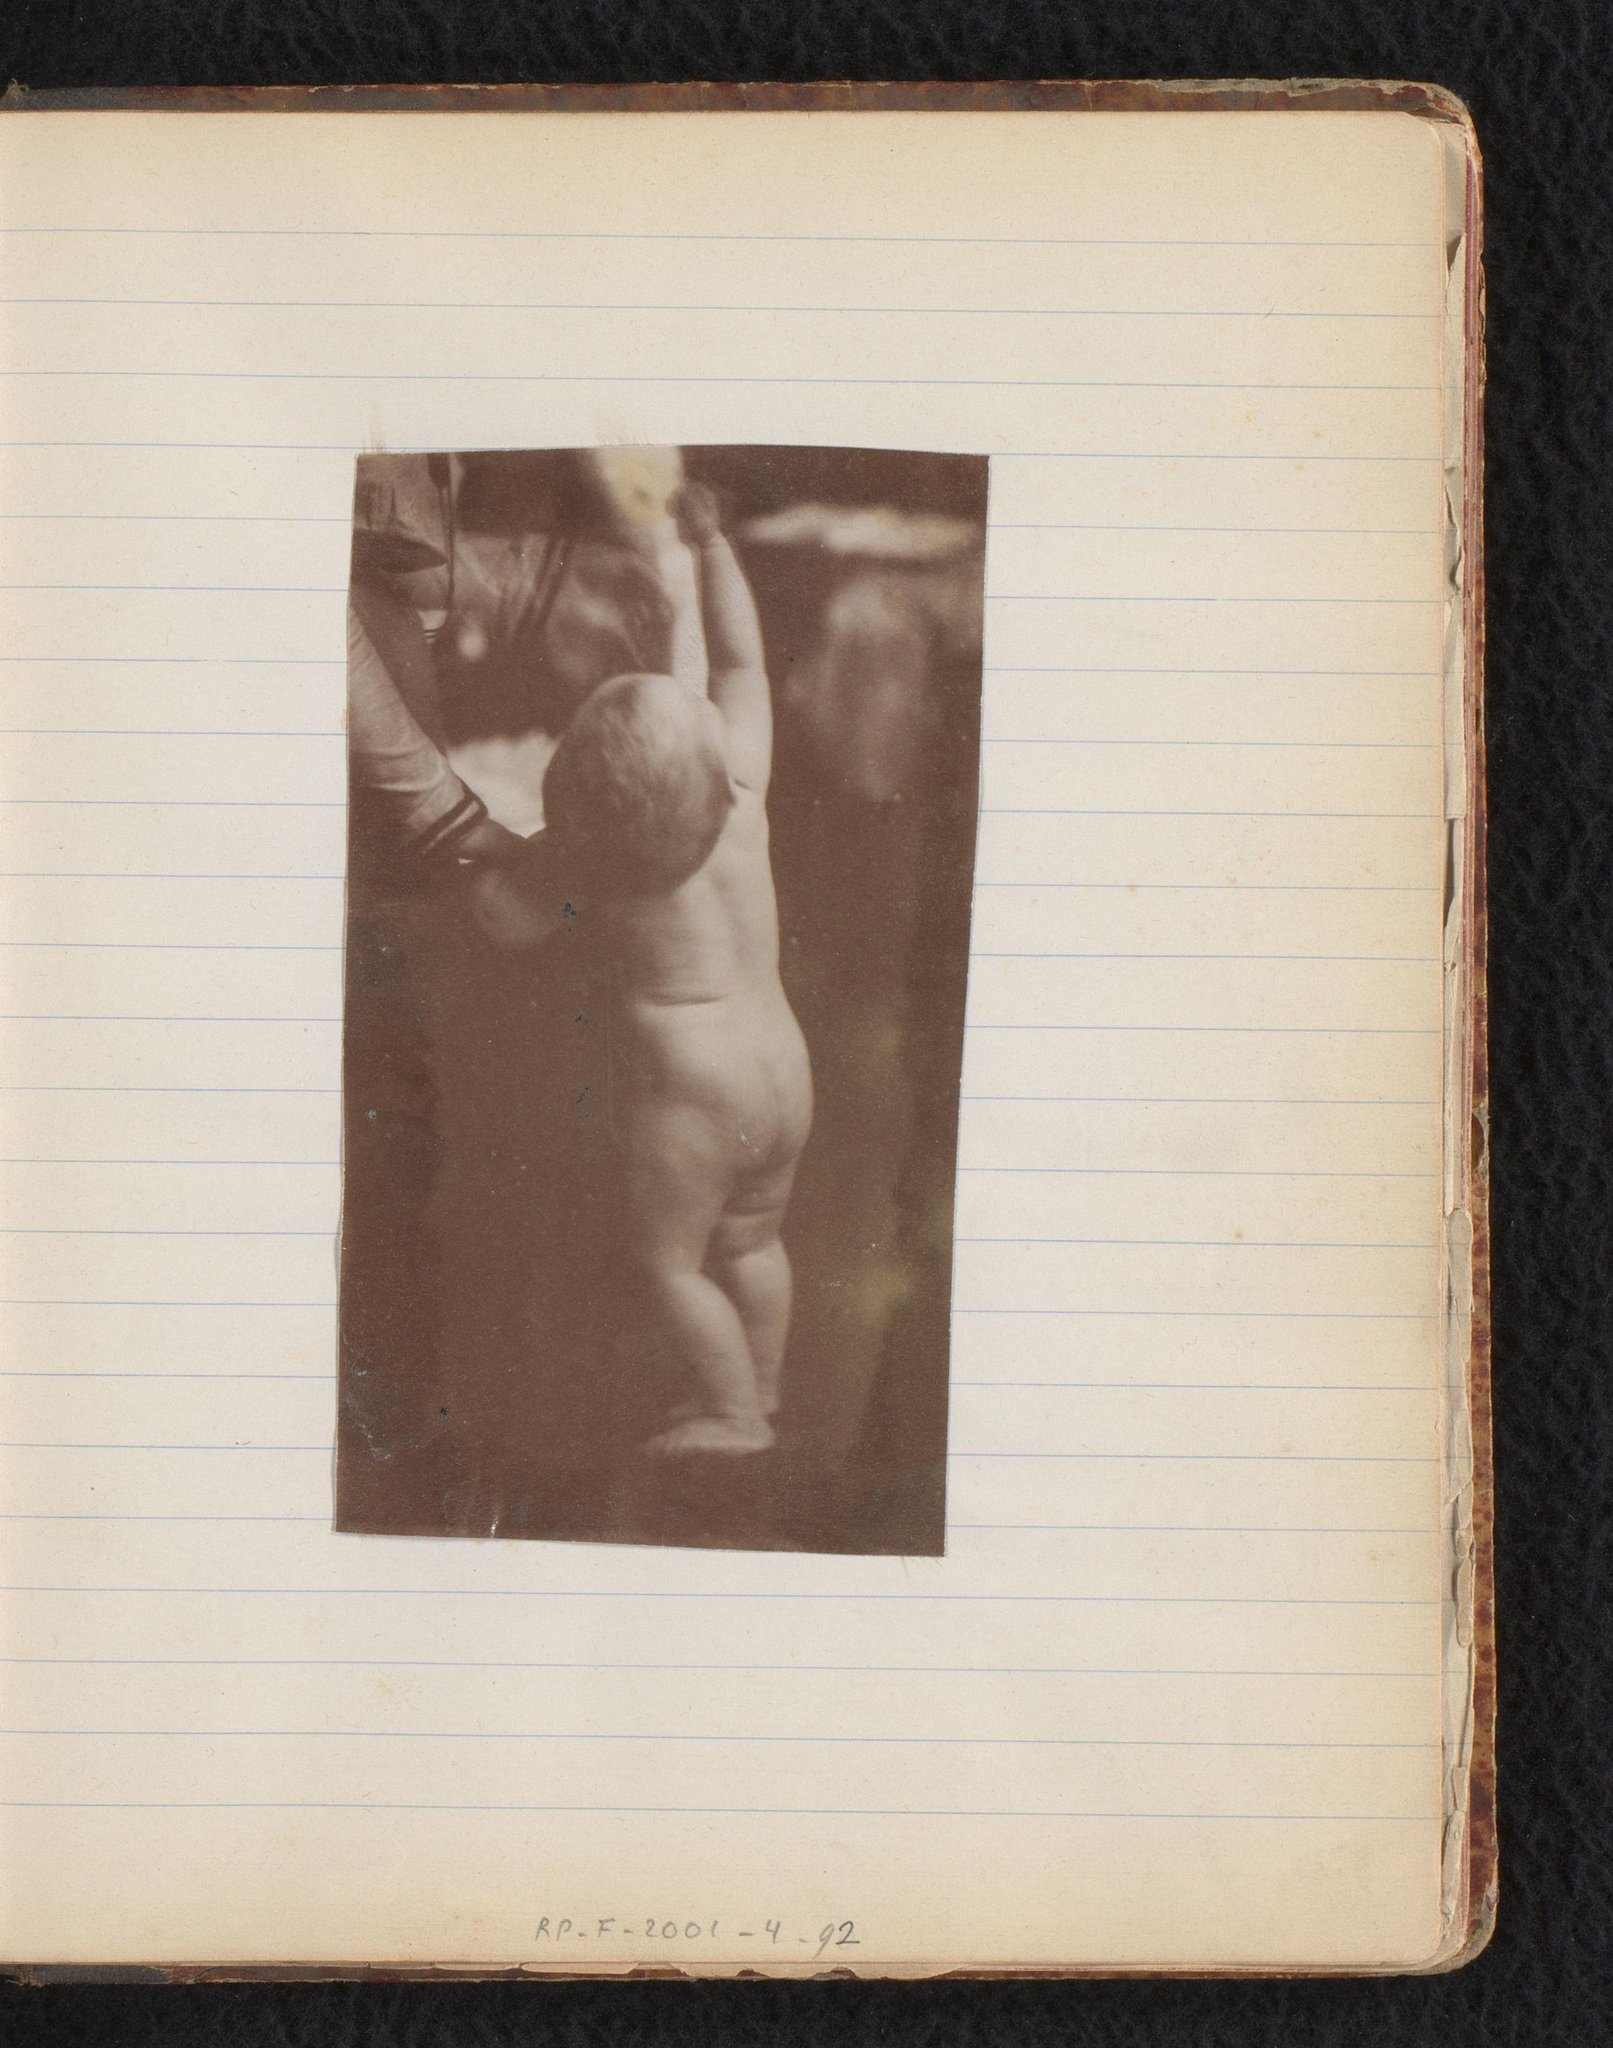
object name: photograph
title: Studie van een naakte peuter en vrouw, door Jacques de Lalaing, voorstudie voor Heilige Maagd met het kind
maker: jacques lalaing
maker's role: painter, sculptor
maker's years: 1858-1917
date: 1900-1914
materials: photographic support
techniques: albumen print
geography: brussels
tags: infant, baby, artist (in general) working from nude model, the (nude) human figure; 'corpo humano' (ripa) (+ back view)